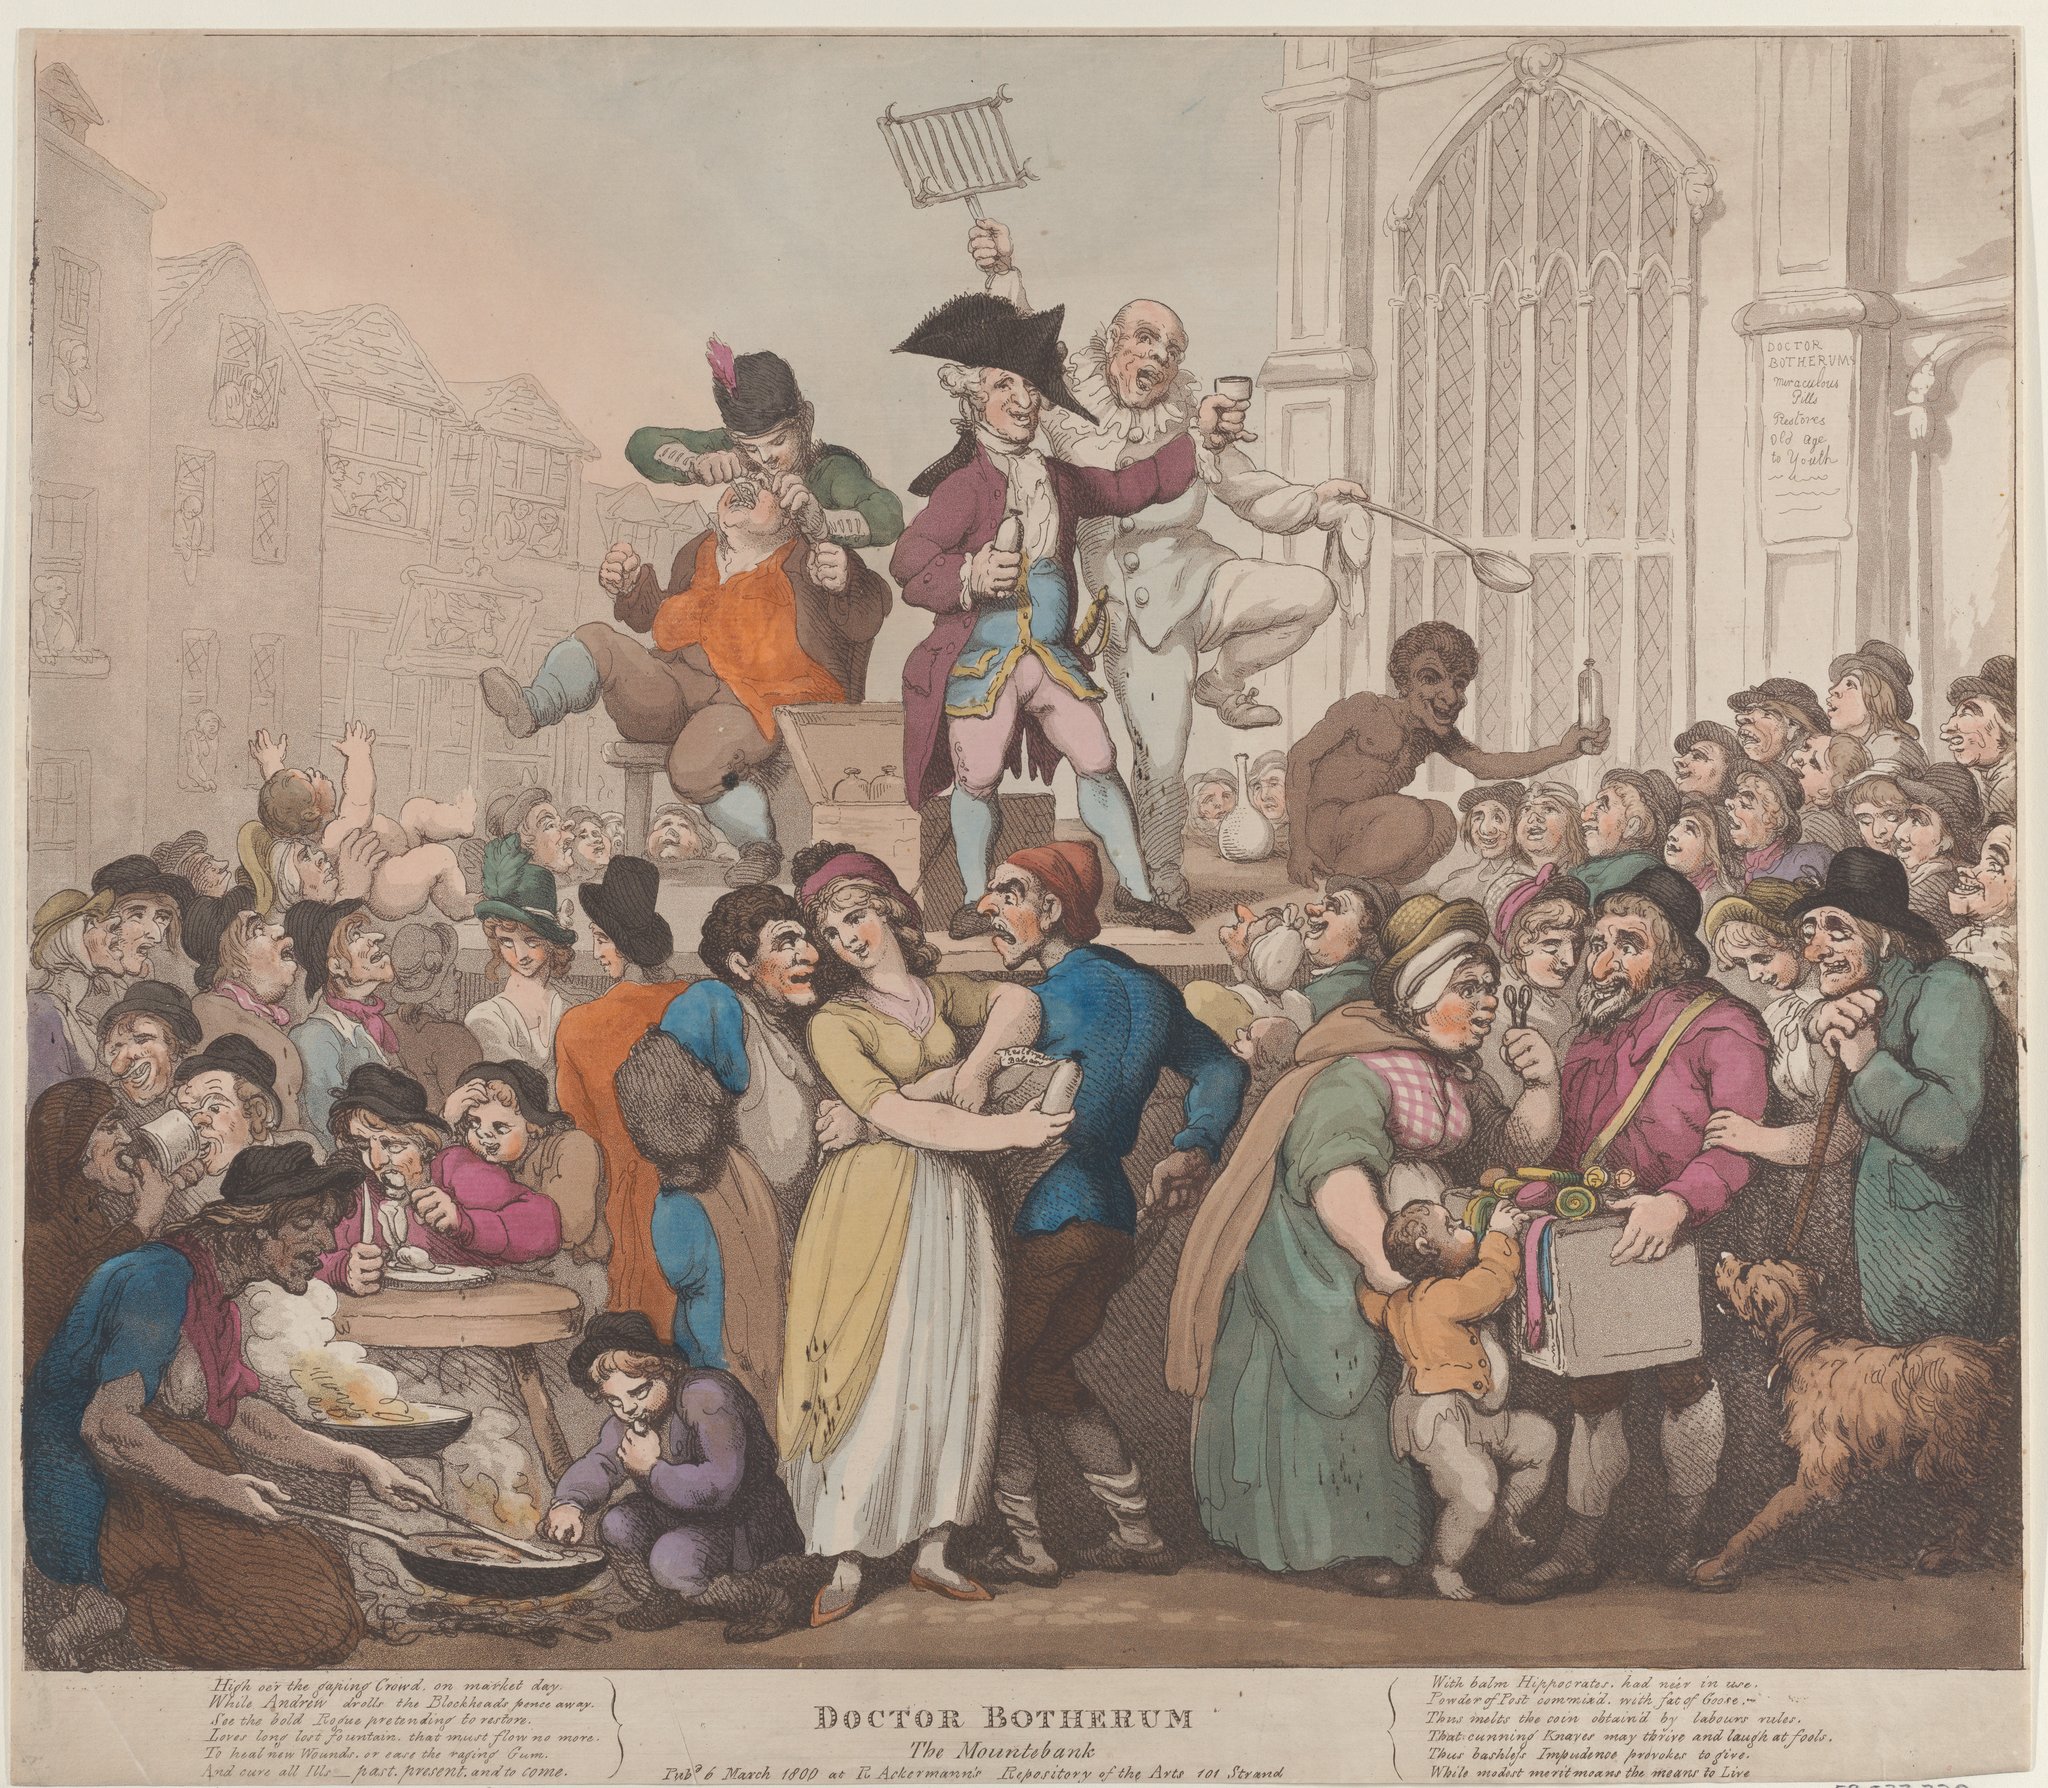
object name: print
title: Doctor Botherum, The Montebank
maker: thomas rowlandson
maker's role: artist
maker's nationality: british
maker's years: 1757-1827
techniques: aquatint, etching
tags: satire,children,men,women,dogs